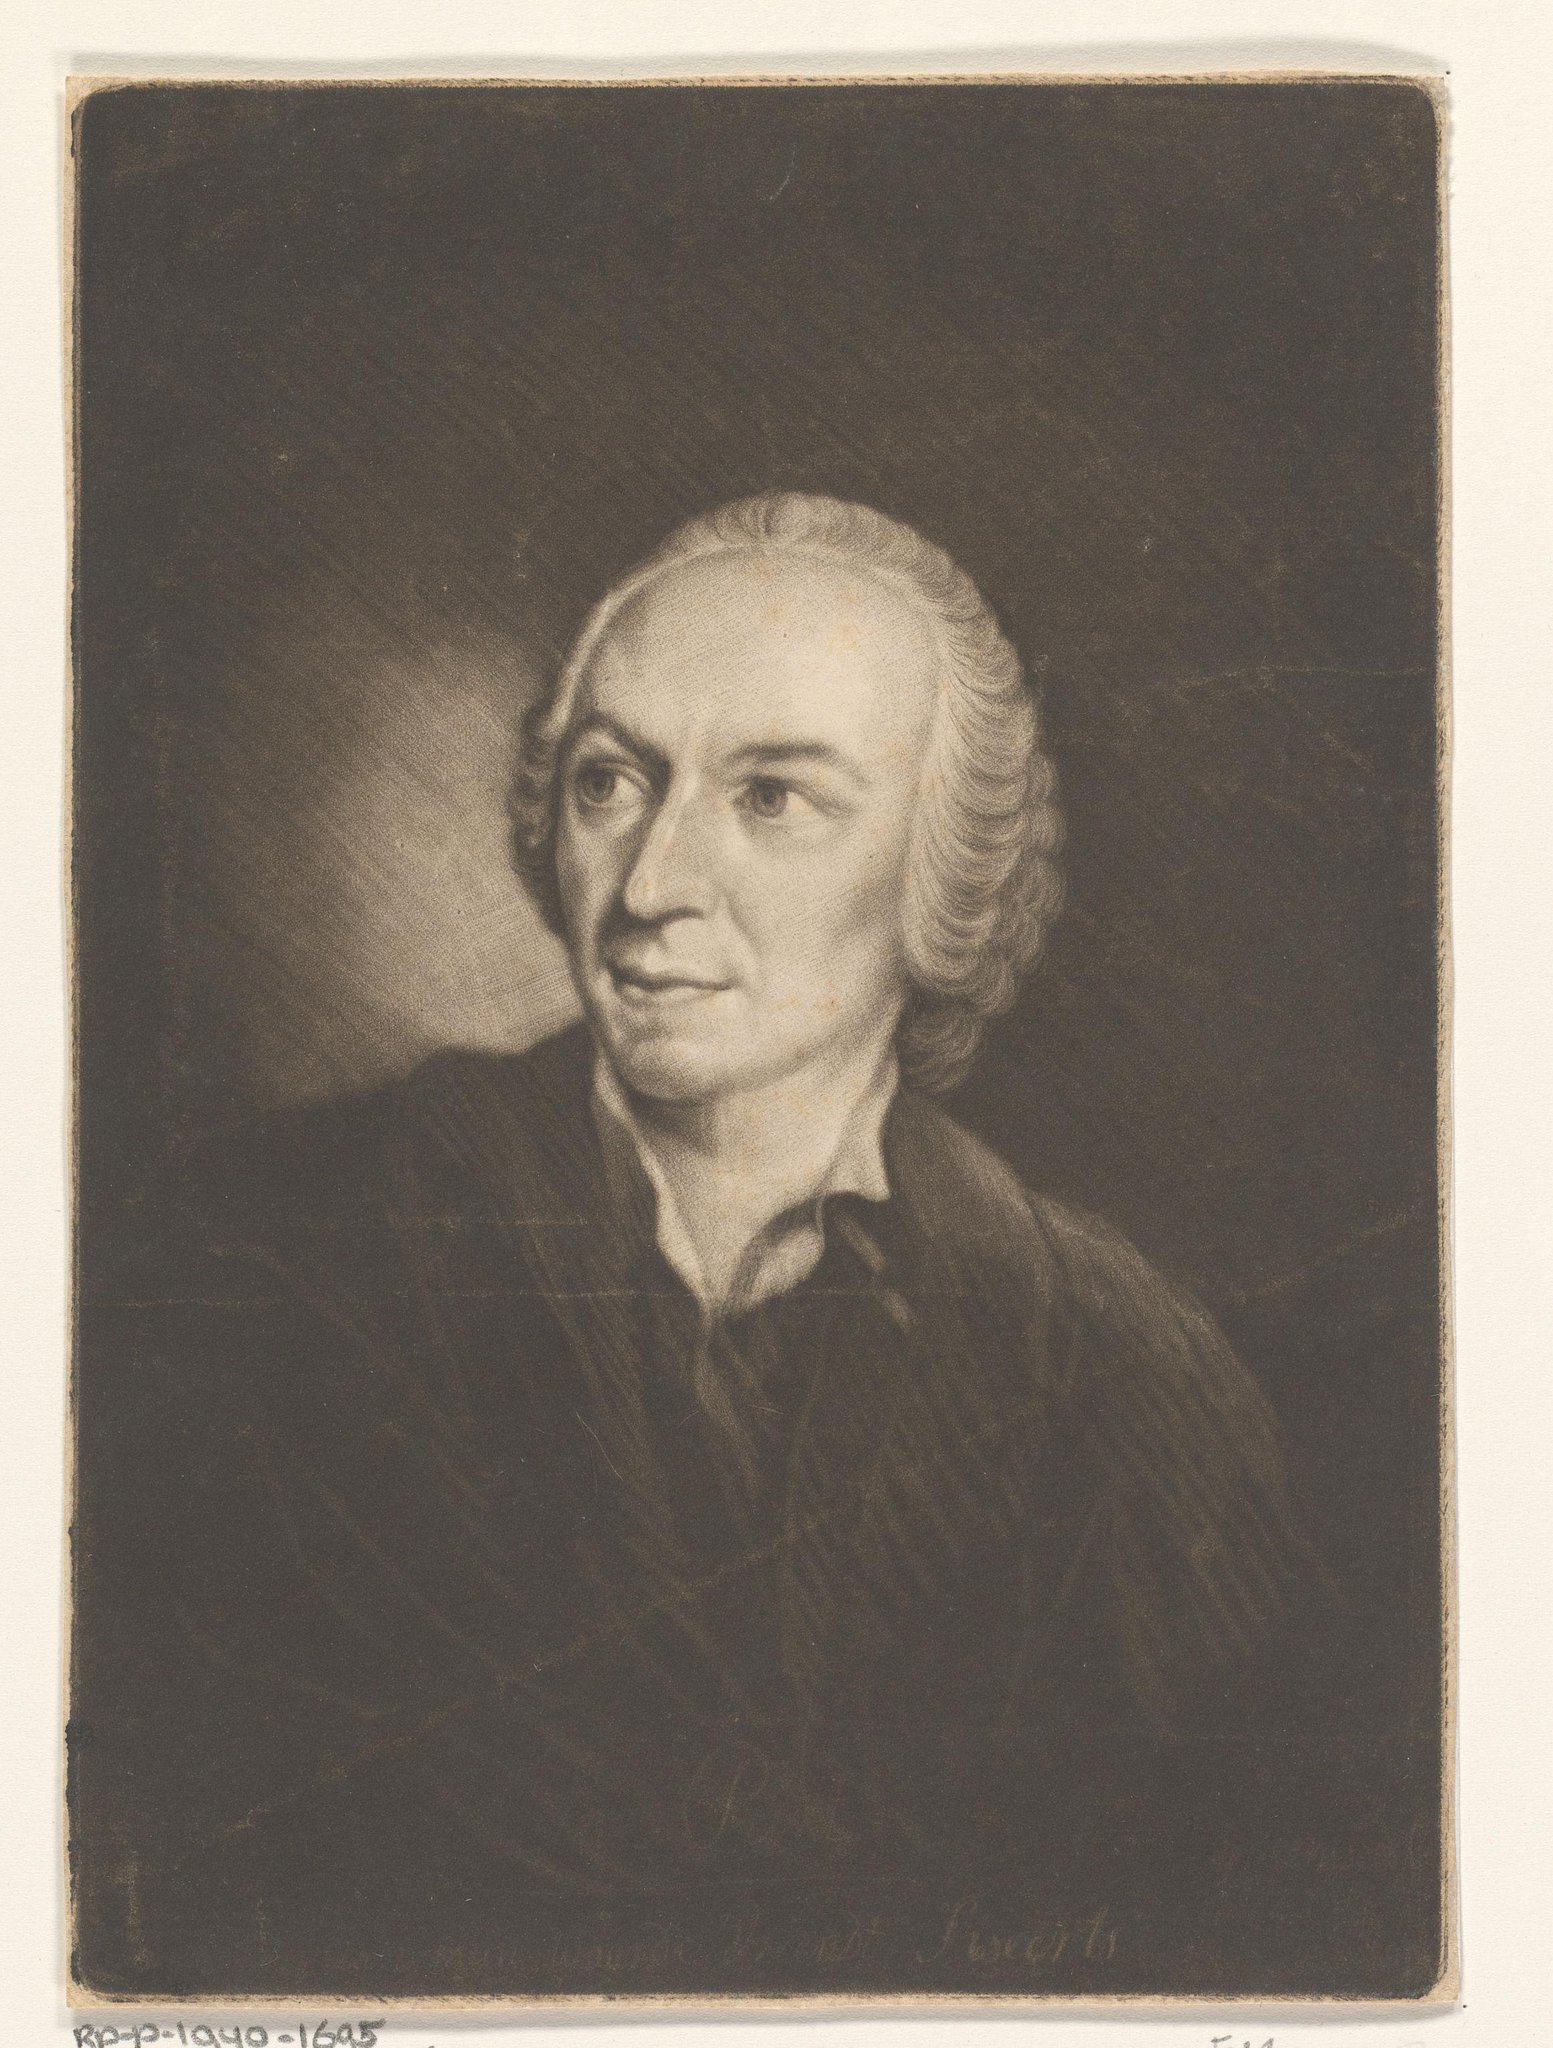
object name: print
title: Portret van Jan Punt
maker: john greenwood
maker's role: auctioneer, draughtsman, print maker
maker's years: 1727-1792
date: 1751-1792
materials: paper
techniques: mezzotint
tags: amsterdam, jan punt, historical persons, portrait, self-portrait of artist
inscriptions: collector's mark: Lugt 2166, collector's mark: Lugt 2760